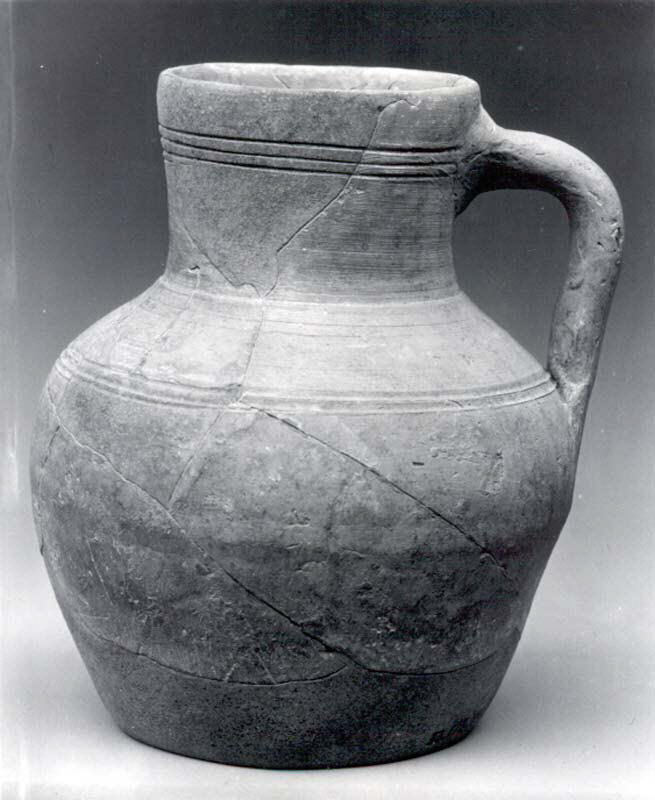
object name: jug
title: Jug with handle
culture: sasanian or islamic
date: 501-800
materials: ceramic, glaze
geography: iran